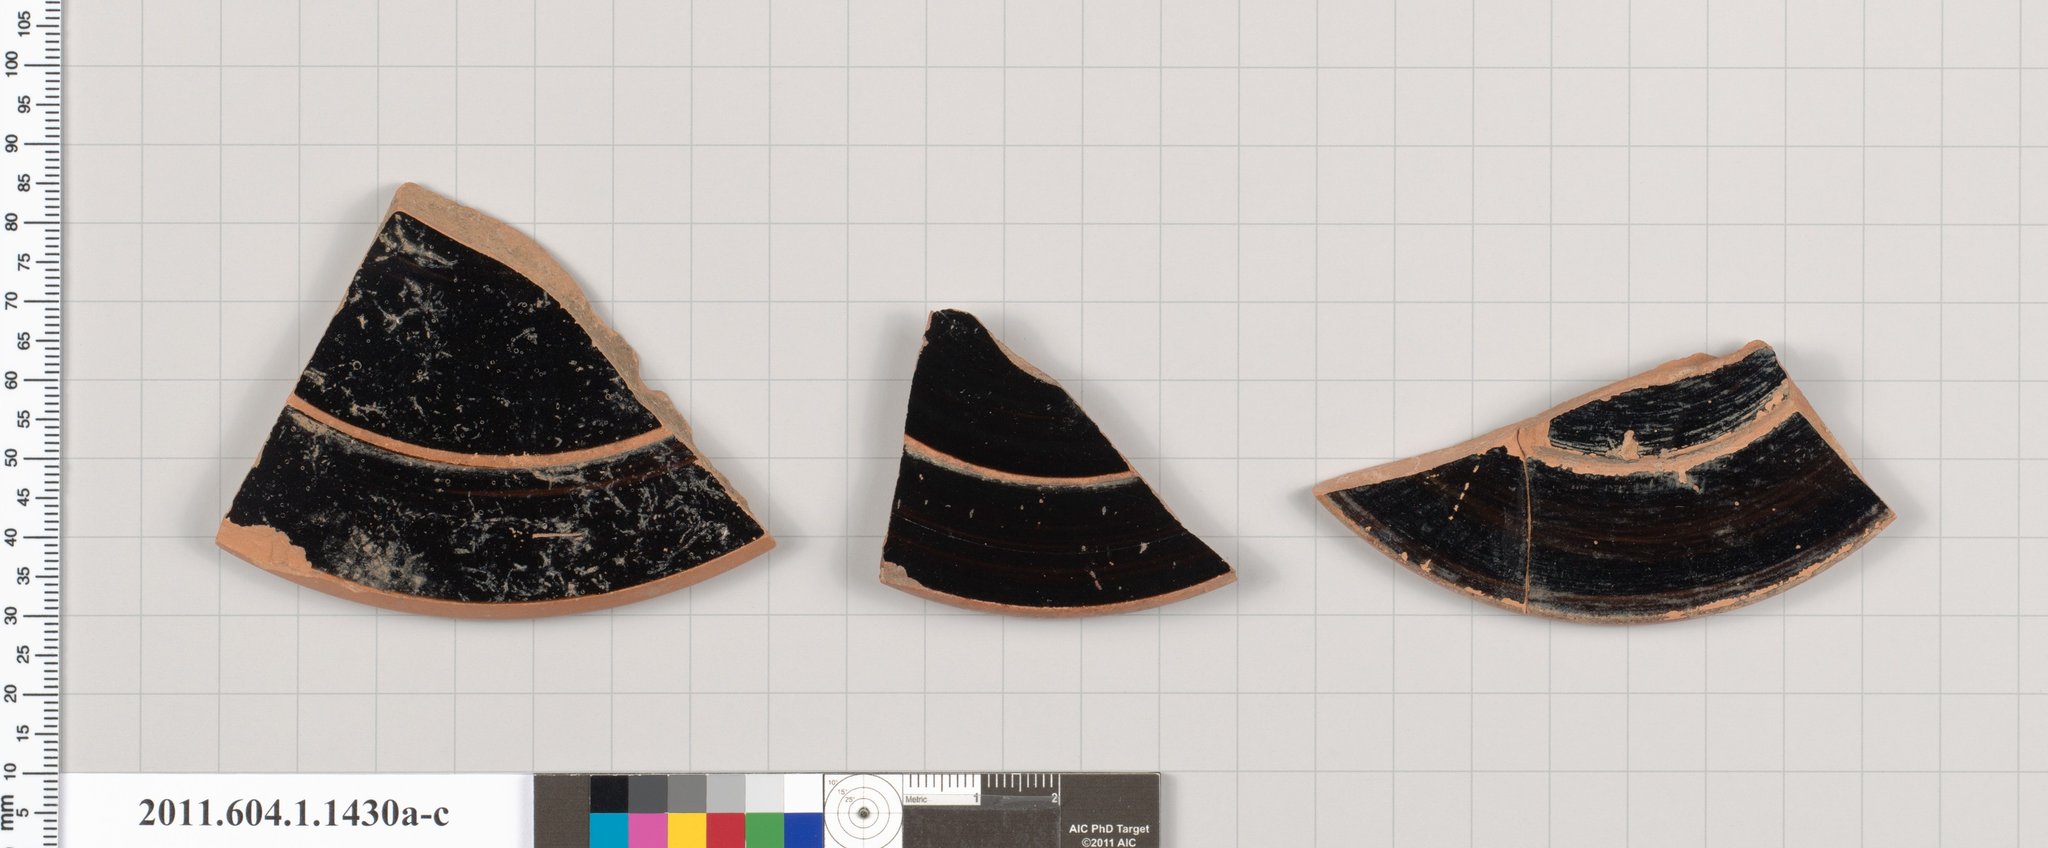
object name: kylix fragment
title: Terracotta fragments of kylikes (drinking cups)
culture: greek, attic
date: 500-401 BCE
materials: terracotta